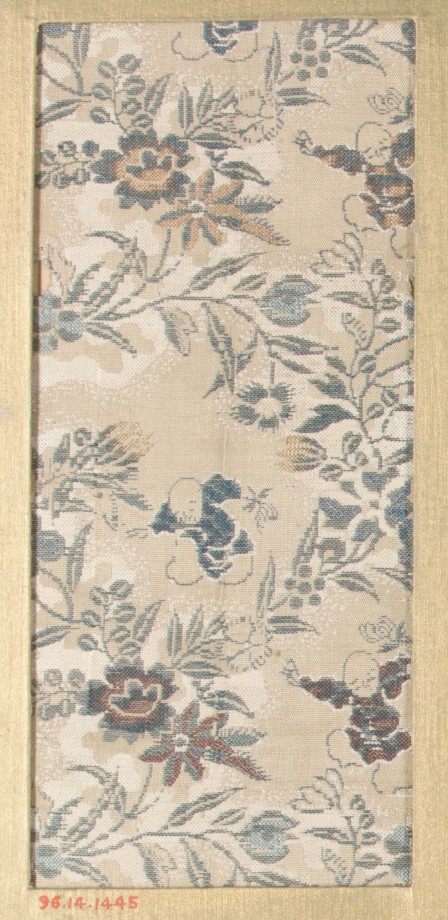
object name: piece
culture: japanese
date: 1701-1900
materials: silk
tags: flowers,leaves